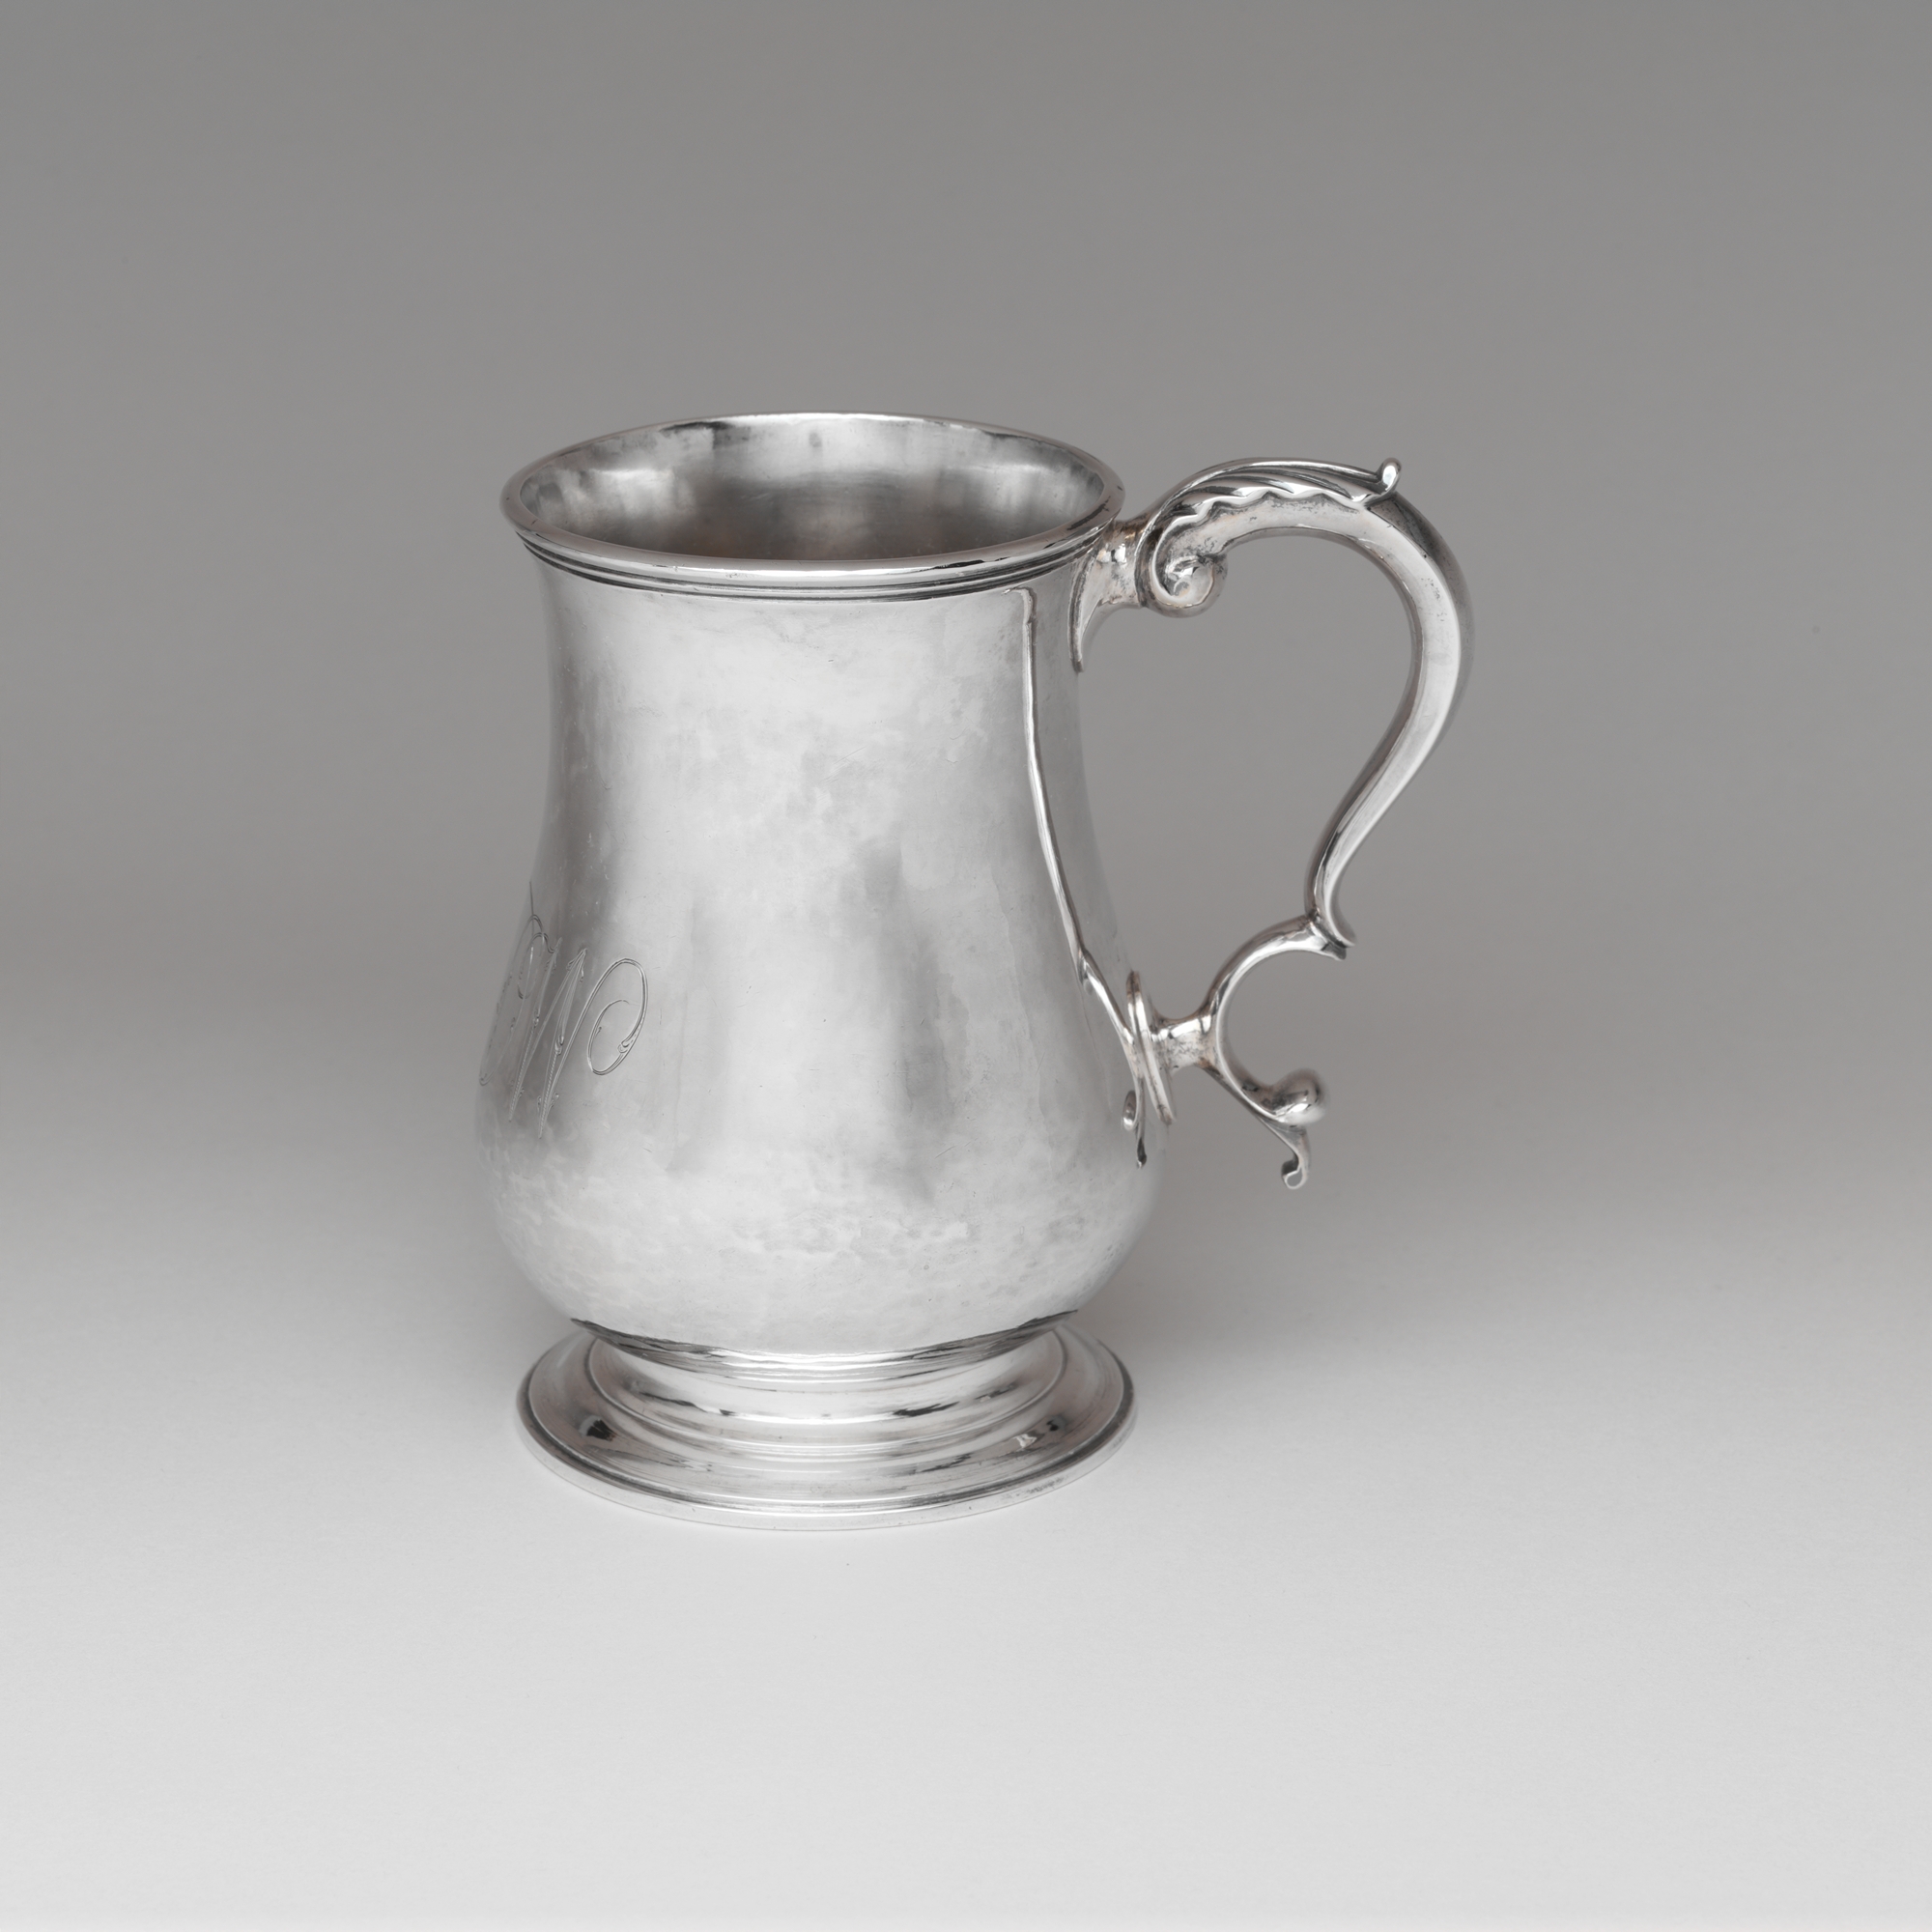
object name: cann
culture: american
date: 1775-1800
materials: silver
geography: united states